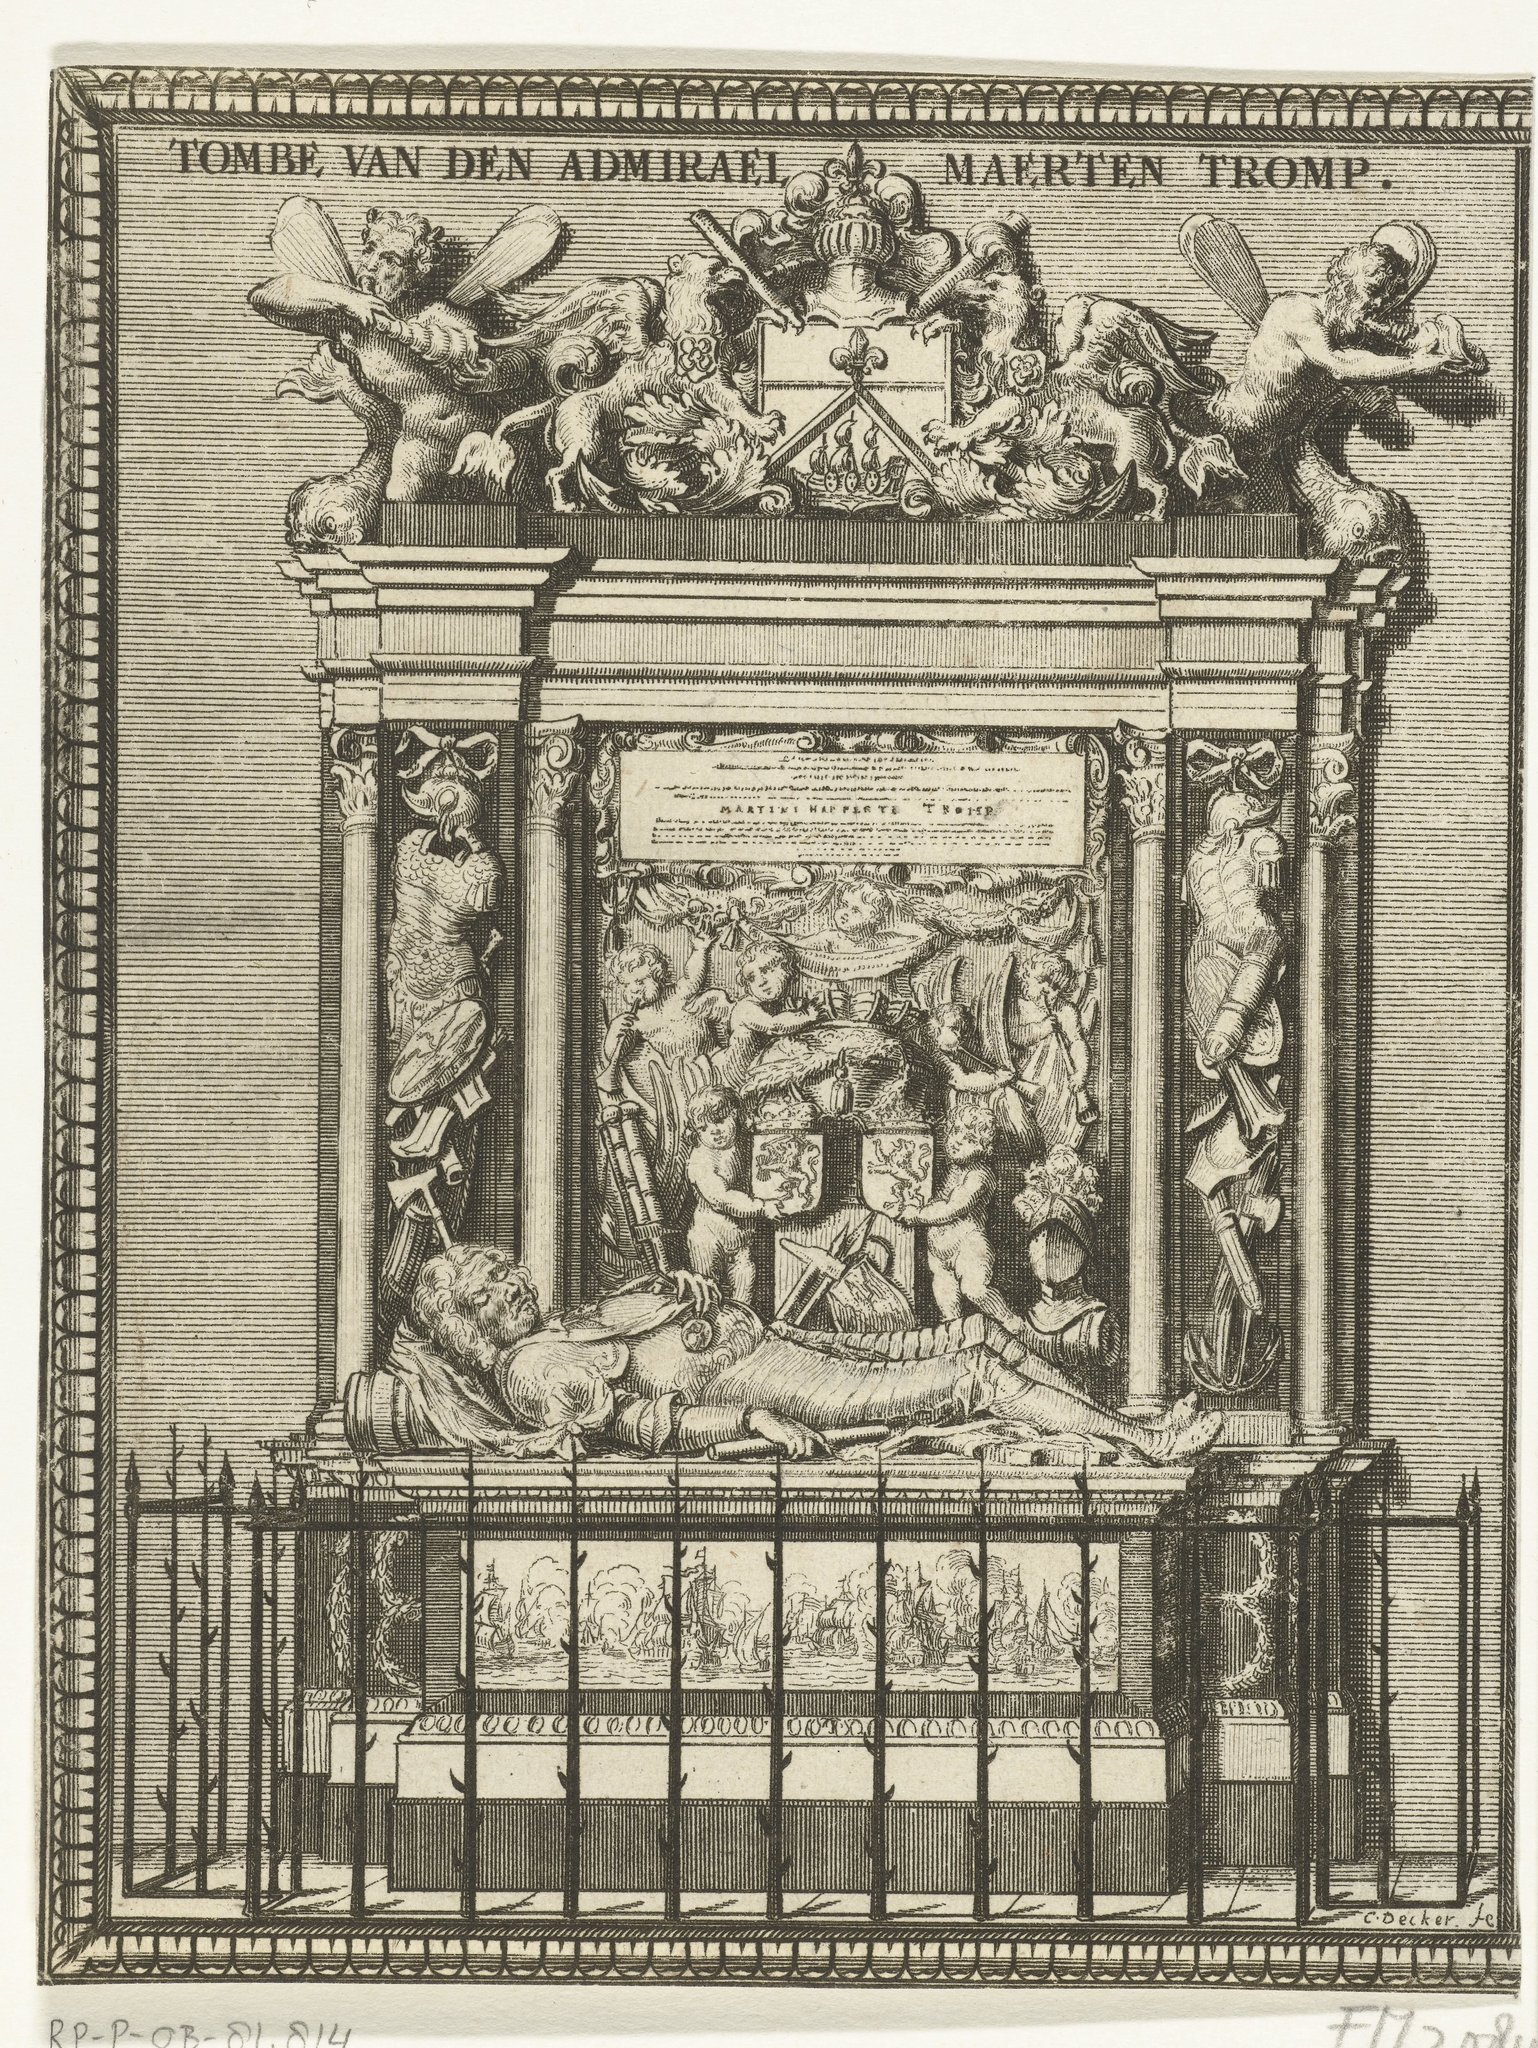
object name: historical object representation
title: Tombe van den admirael Maerten tromp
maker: coenraet decker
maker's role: print maker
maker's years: 1650-1685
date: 1665-1667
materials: paper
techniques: etching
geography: northern netherlands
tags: brielle, maarten harpertszoon tromp, grave-building, monumental tomb, battle of scheveningen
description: Niet in Frederik Muller; door het RPK toegevoegd nummer. Gebruikt als illustratie in: Dirck van Bleyswijck, Beschryvinge der stadt Delft, Arn. Bon, Delft 1667.